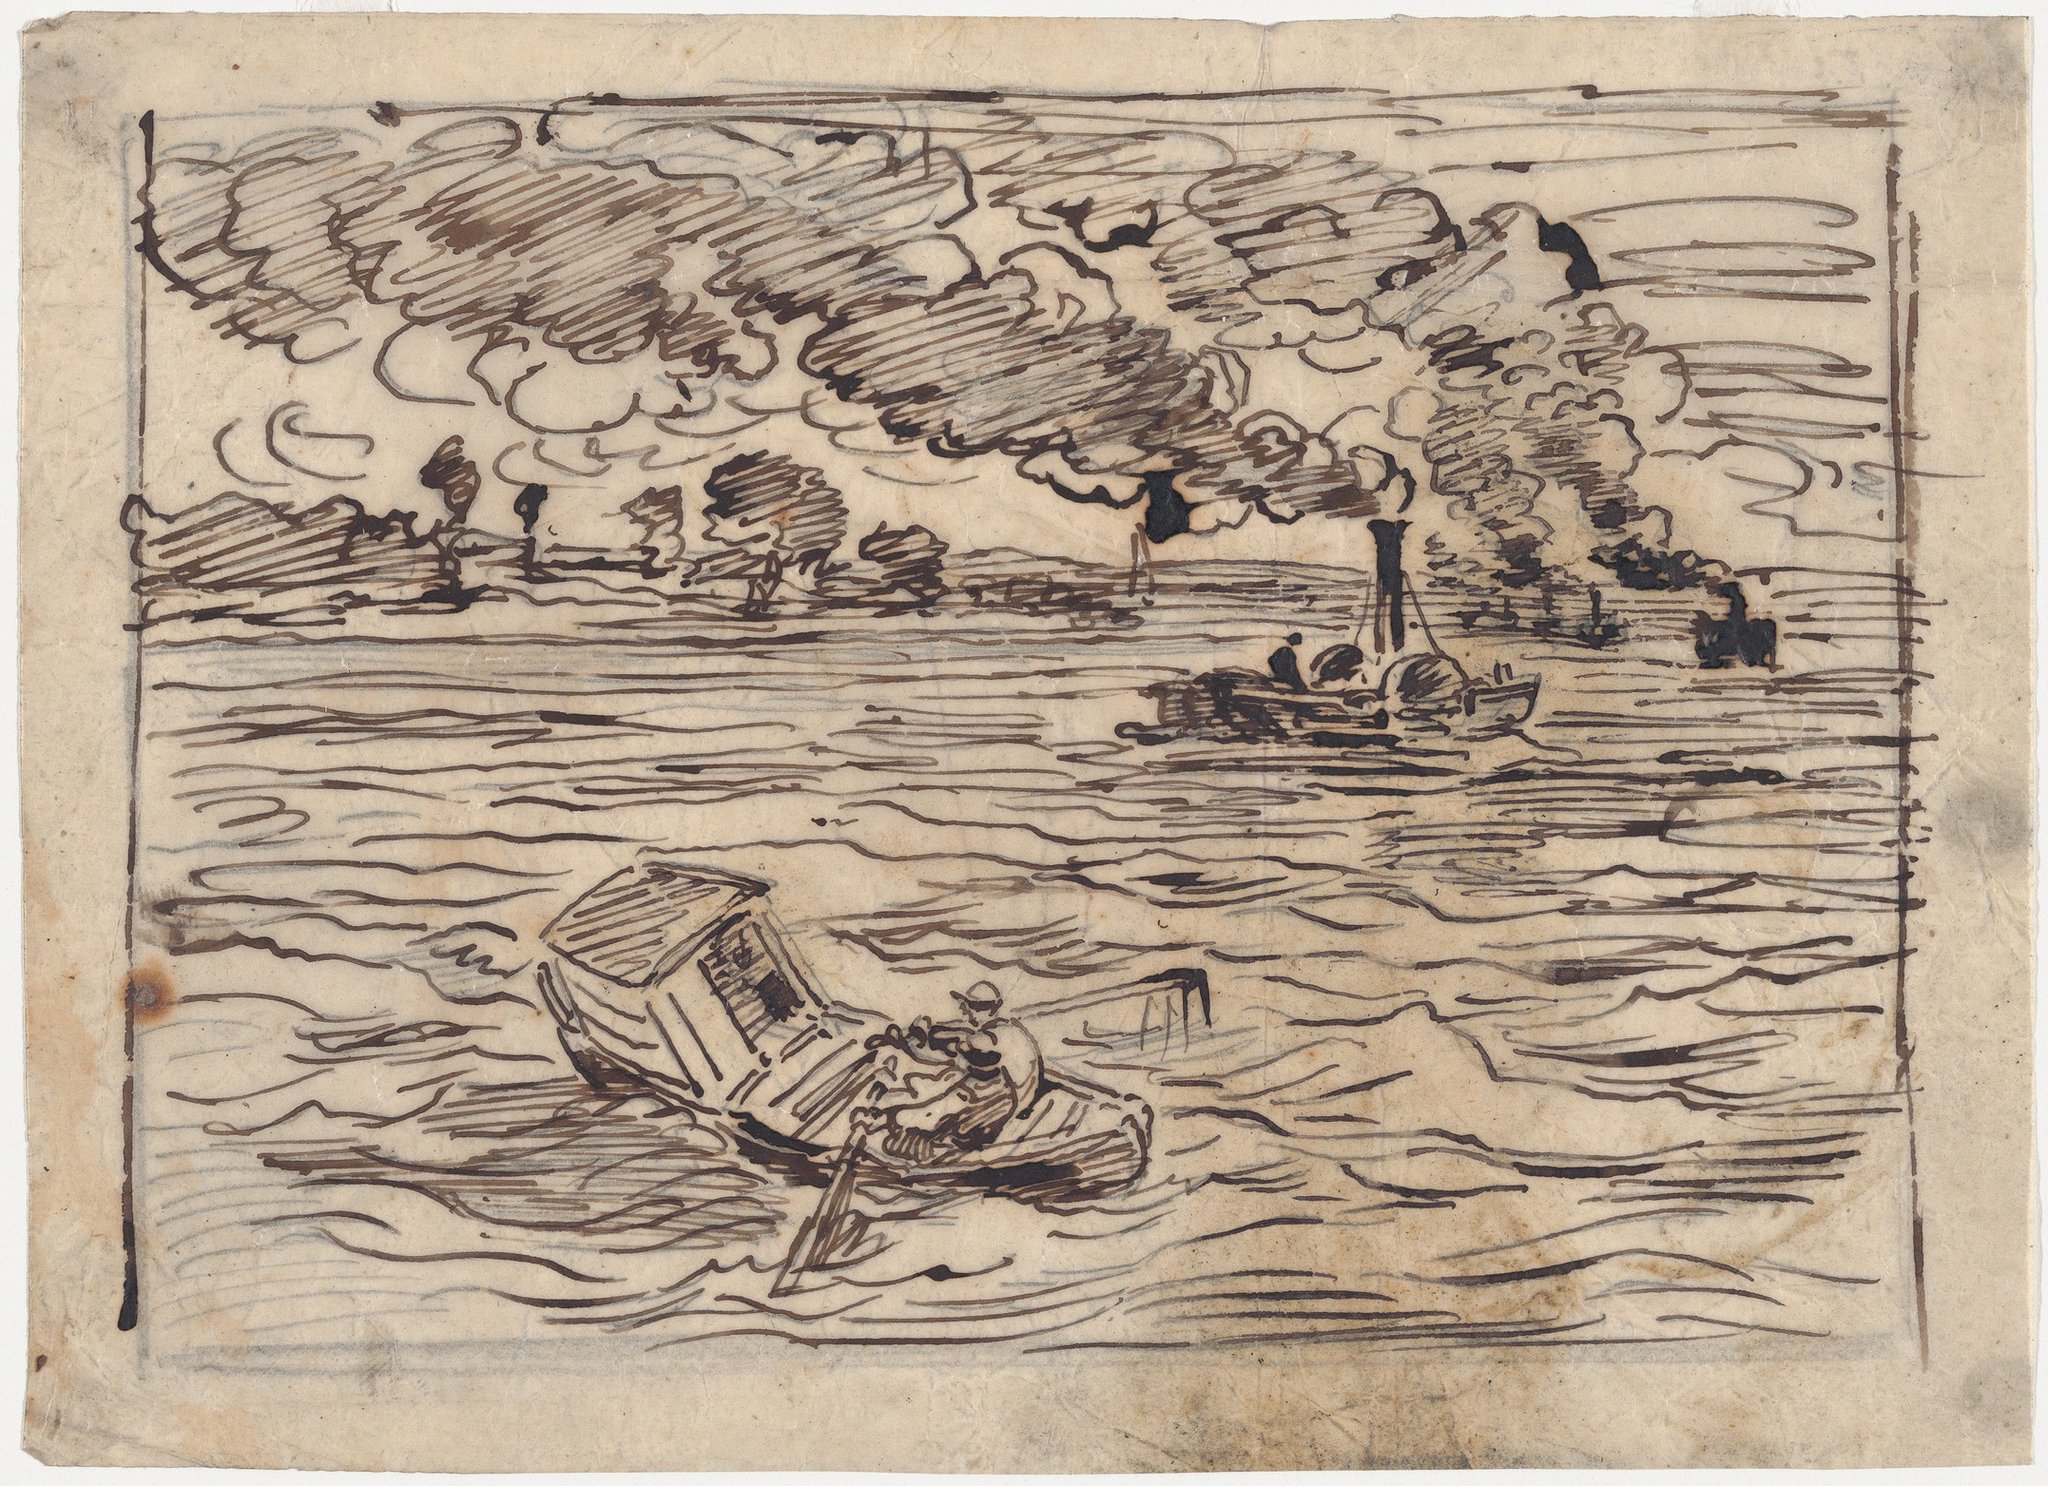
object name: drawing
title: The Steamboats or Watch Out for the Steamers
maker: charles-françois daubigny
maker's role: artist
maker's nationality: french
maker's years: 1817-1878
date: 1862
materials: graphite, ink, paper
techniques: pen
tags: boats